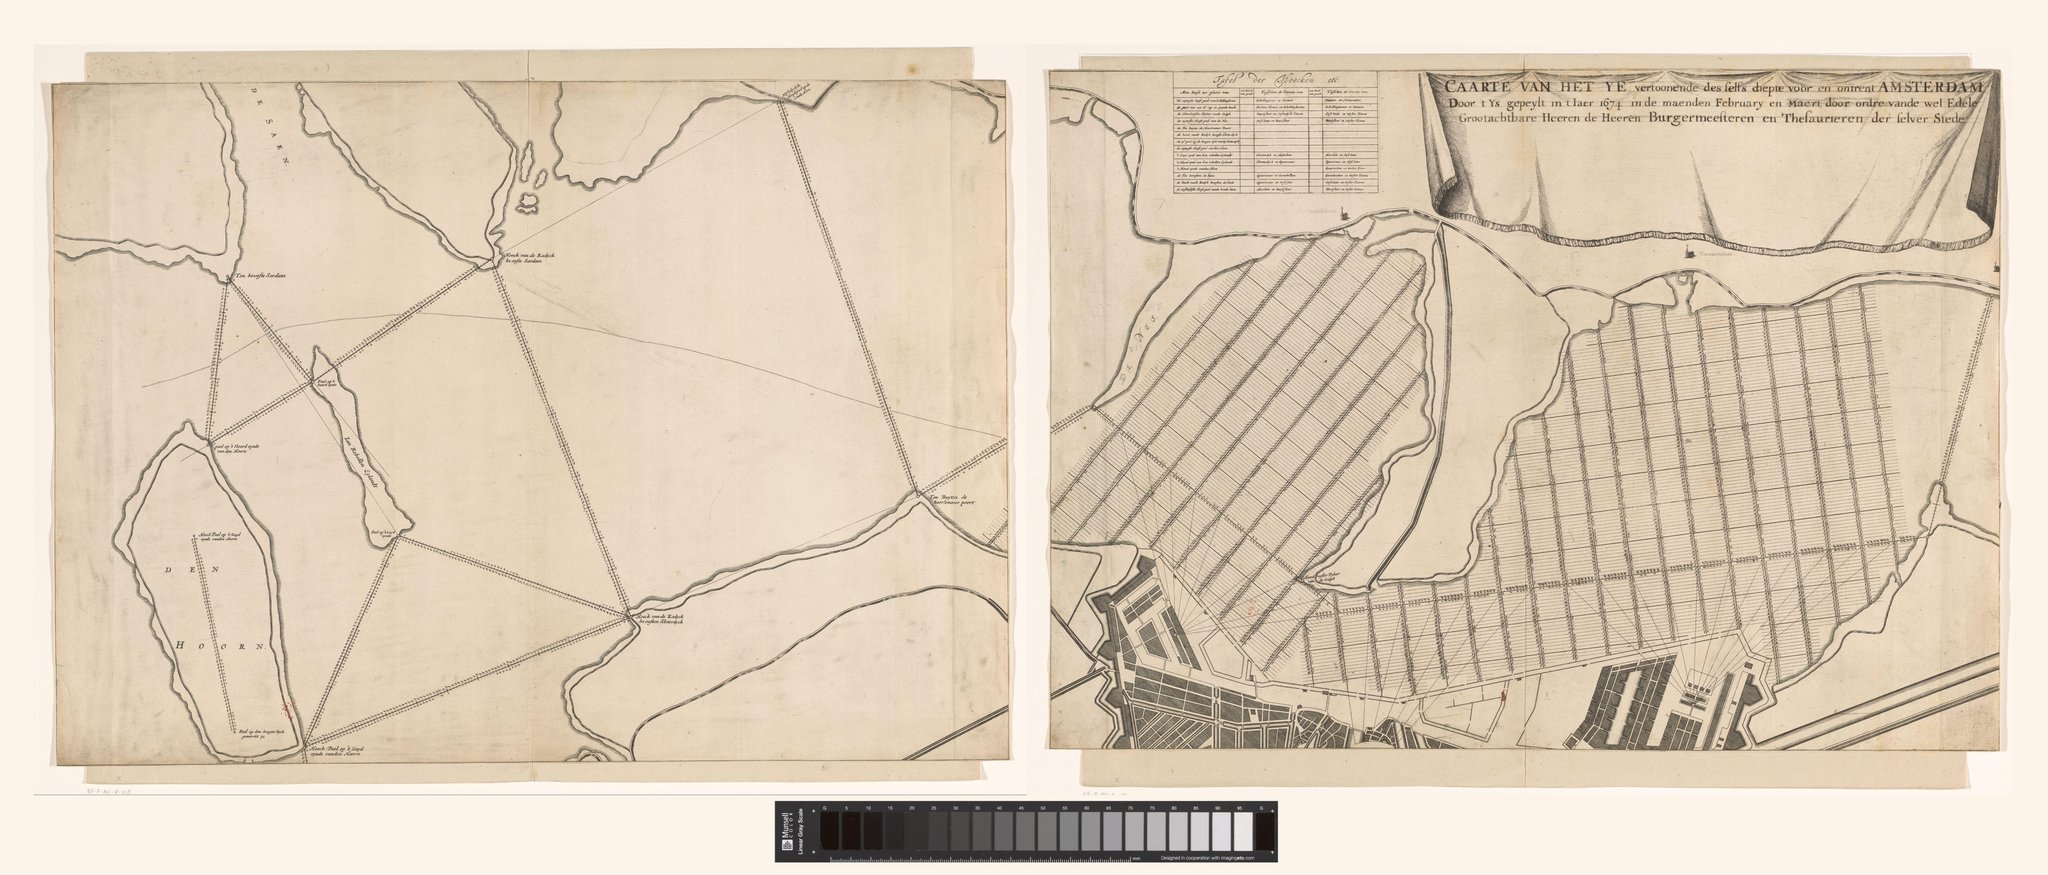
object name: map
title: Caarte van het Ye; vertoonende des selfs diepte voor en ontrent Amsterdam door 't ys gepeylt in 't iaer 1674 in de maenden february en maert, door ordre vande wel edele grootachtbare heeren de heeren burgermeesteren en thesaurieren der selver stede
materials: ink, paper, pencil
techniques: engraving, etching, pen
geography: amsterdam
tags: maps of separate countries or regions, river, maps of cities, amsterdam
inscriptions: inscription, collector's mark: Lugt 195, inscription: ‘Caarte van het Ye; vertoonende des selfs diepte voor en ontrent Amsterdam door 't ys gepeylt in 't iaer 1674 in de maenden february en maert, door ordre vande wel edele grootachtbare heeren de heeren burgermeesteren en thesaurieren der selver stede’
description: Dit object is omwille van een betere presentatie virtueel samengevoegd maar bestaat fysiek uit losse onderdelen Dit is een proefdruk; de titel is handgeschreven, net als 'De Nes'. Verder ontbreken nog details en stukken tekst die wel te zien zijn op een latere staat (zelfde titel maar dan gedrukt, een exemplaar in het bezit van de Universiteit Utrecht).